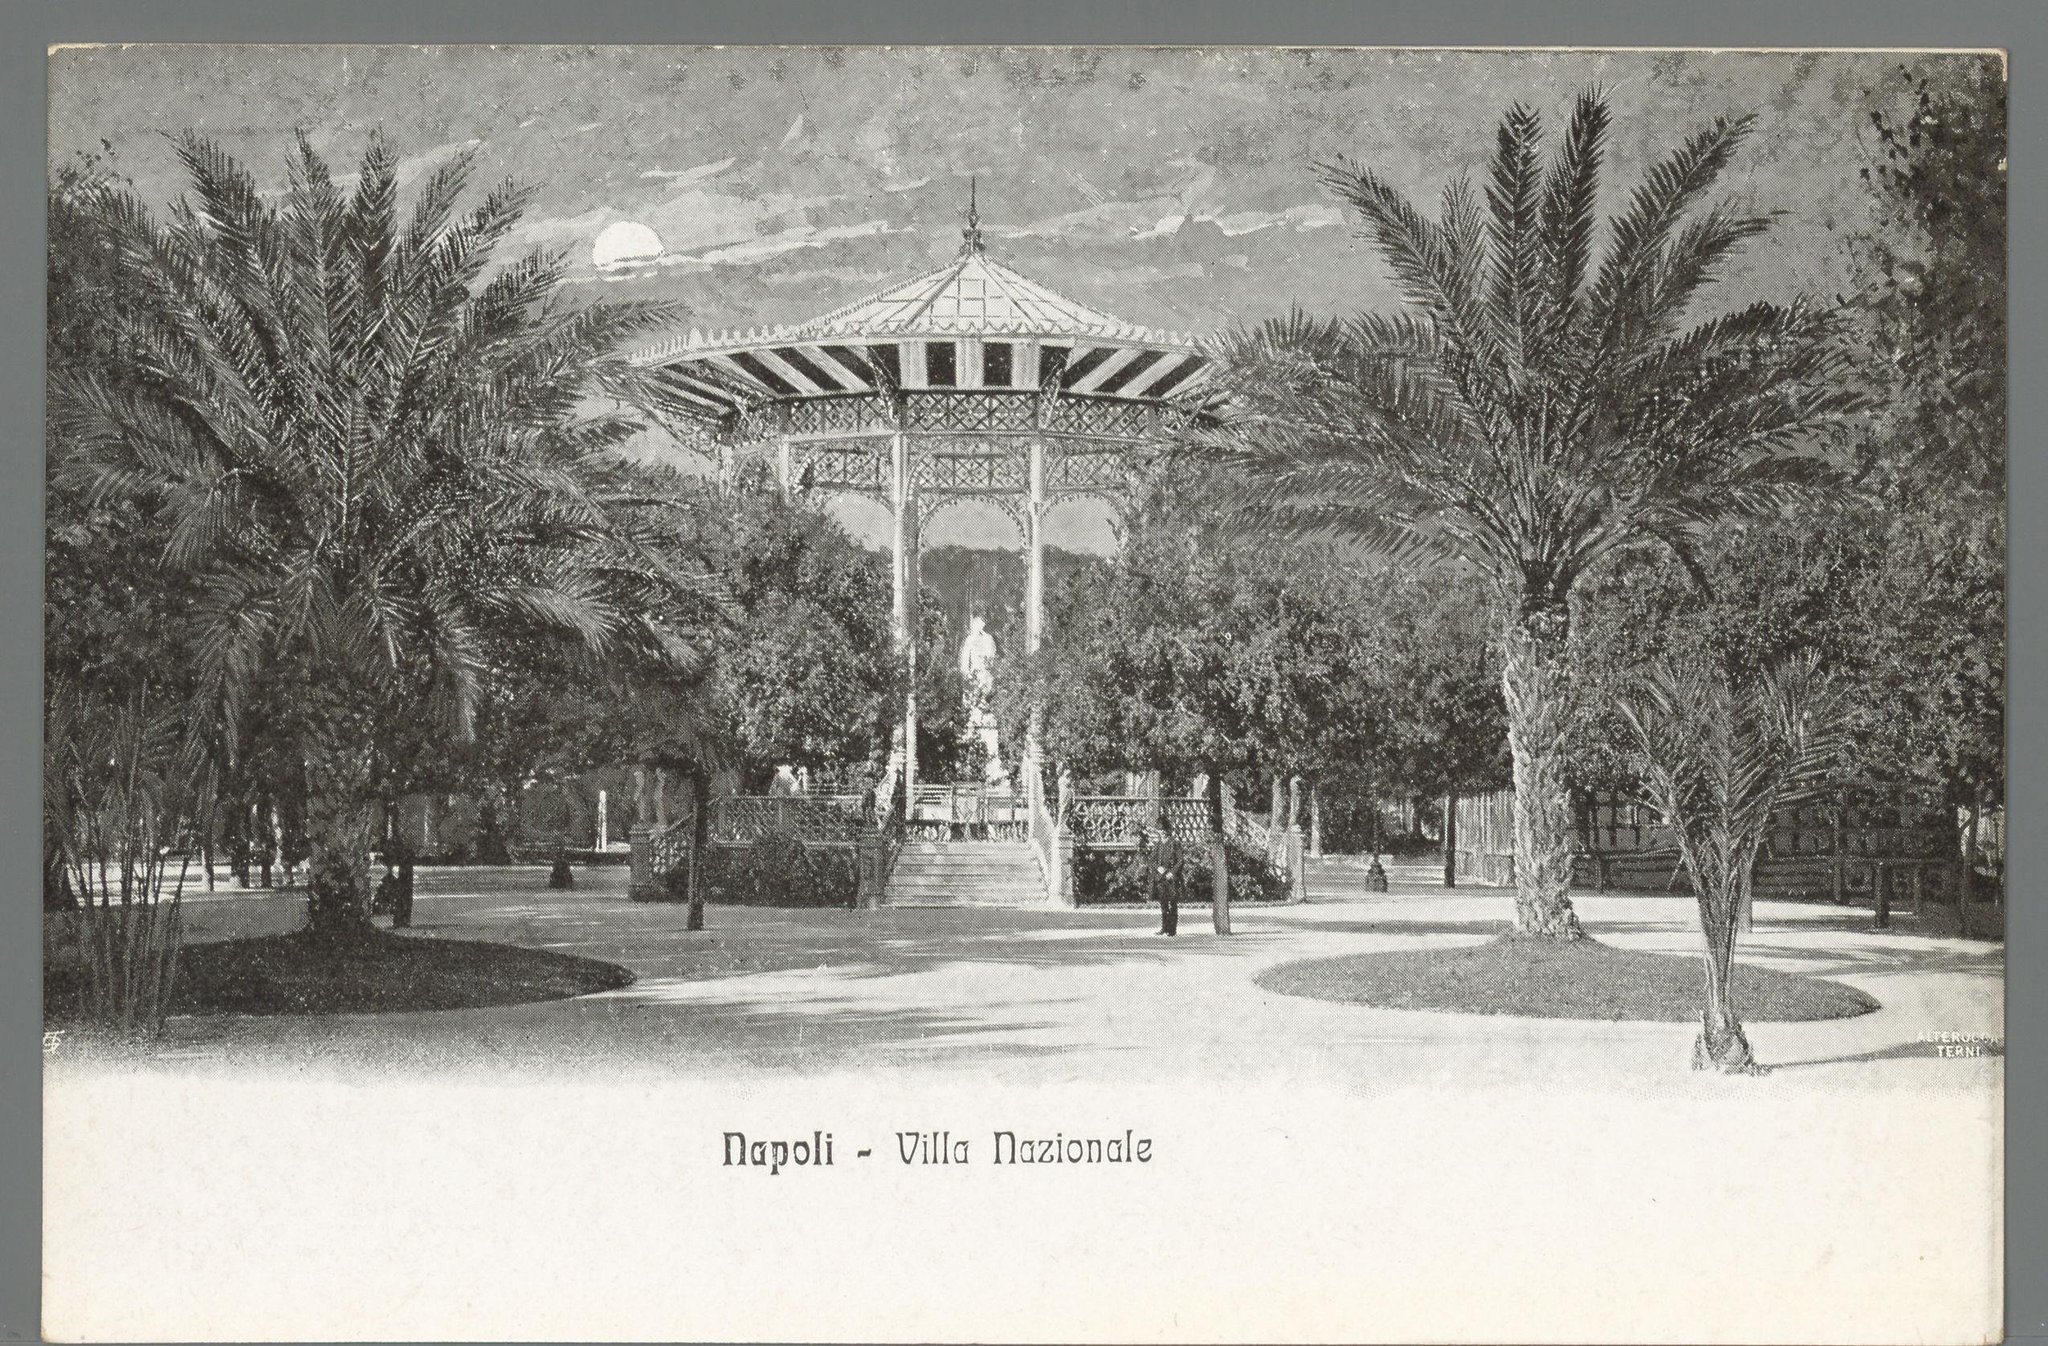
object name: ansichtkaart, prentbriefkaart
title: Napoli. Villa Nazionale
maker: Anonymous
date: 1906-1910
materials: cardboard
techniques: autotype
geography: terni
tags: public gardens, park (+ city(-scape) with figures, staffage), bandstand, trees: palm-tree, naples